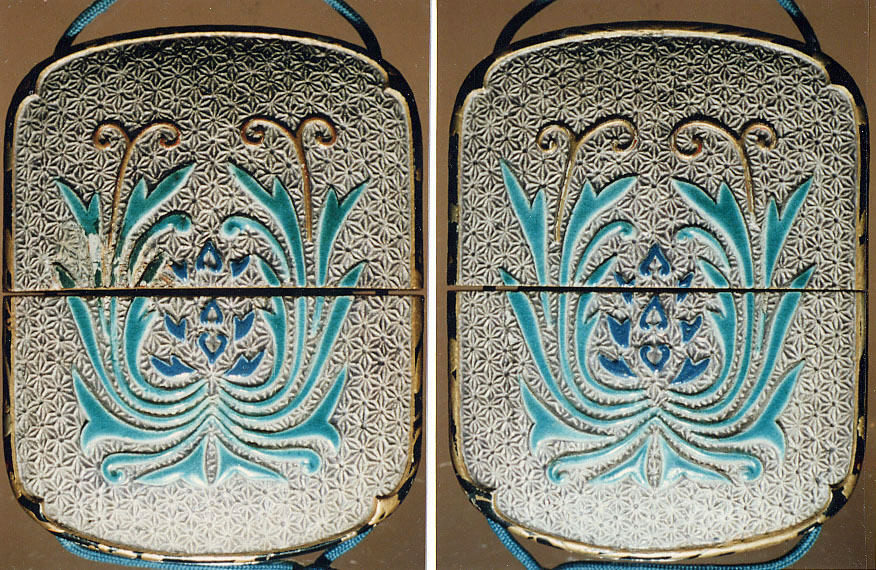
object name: inrō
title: Case (Inrō) with Design of Pottery Plaques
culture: japanese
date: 1820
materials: jade, pottery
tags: flowers